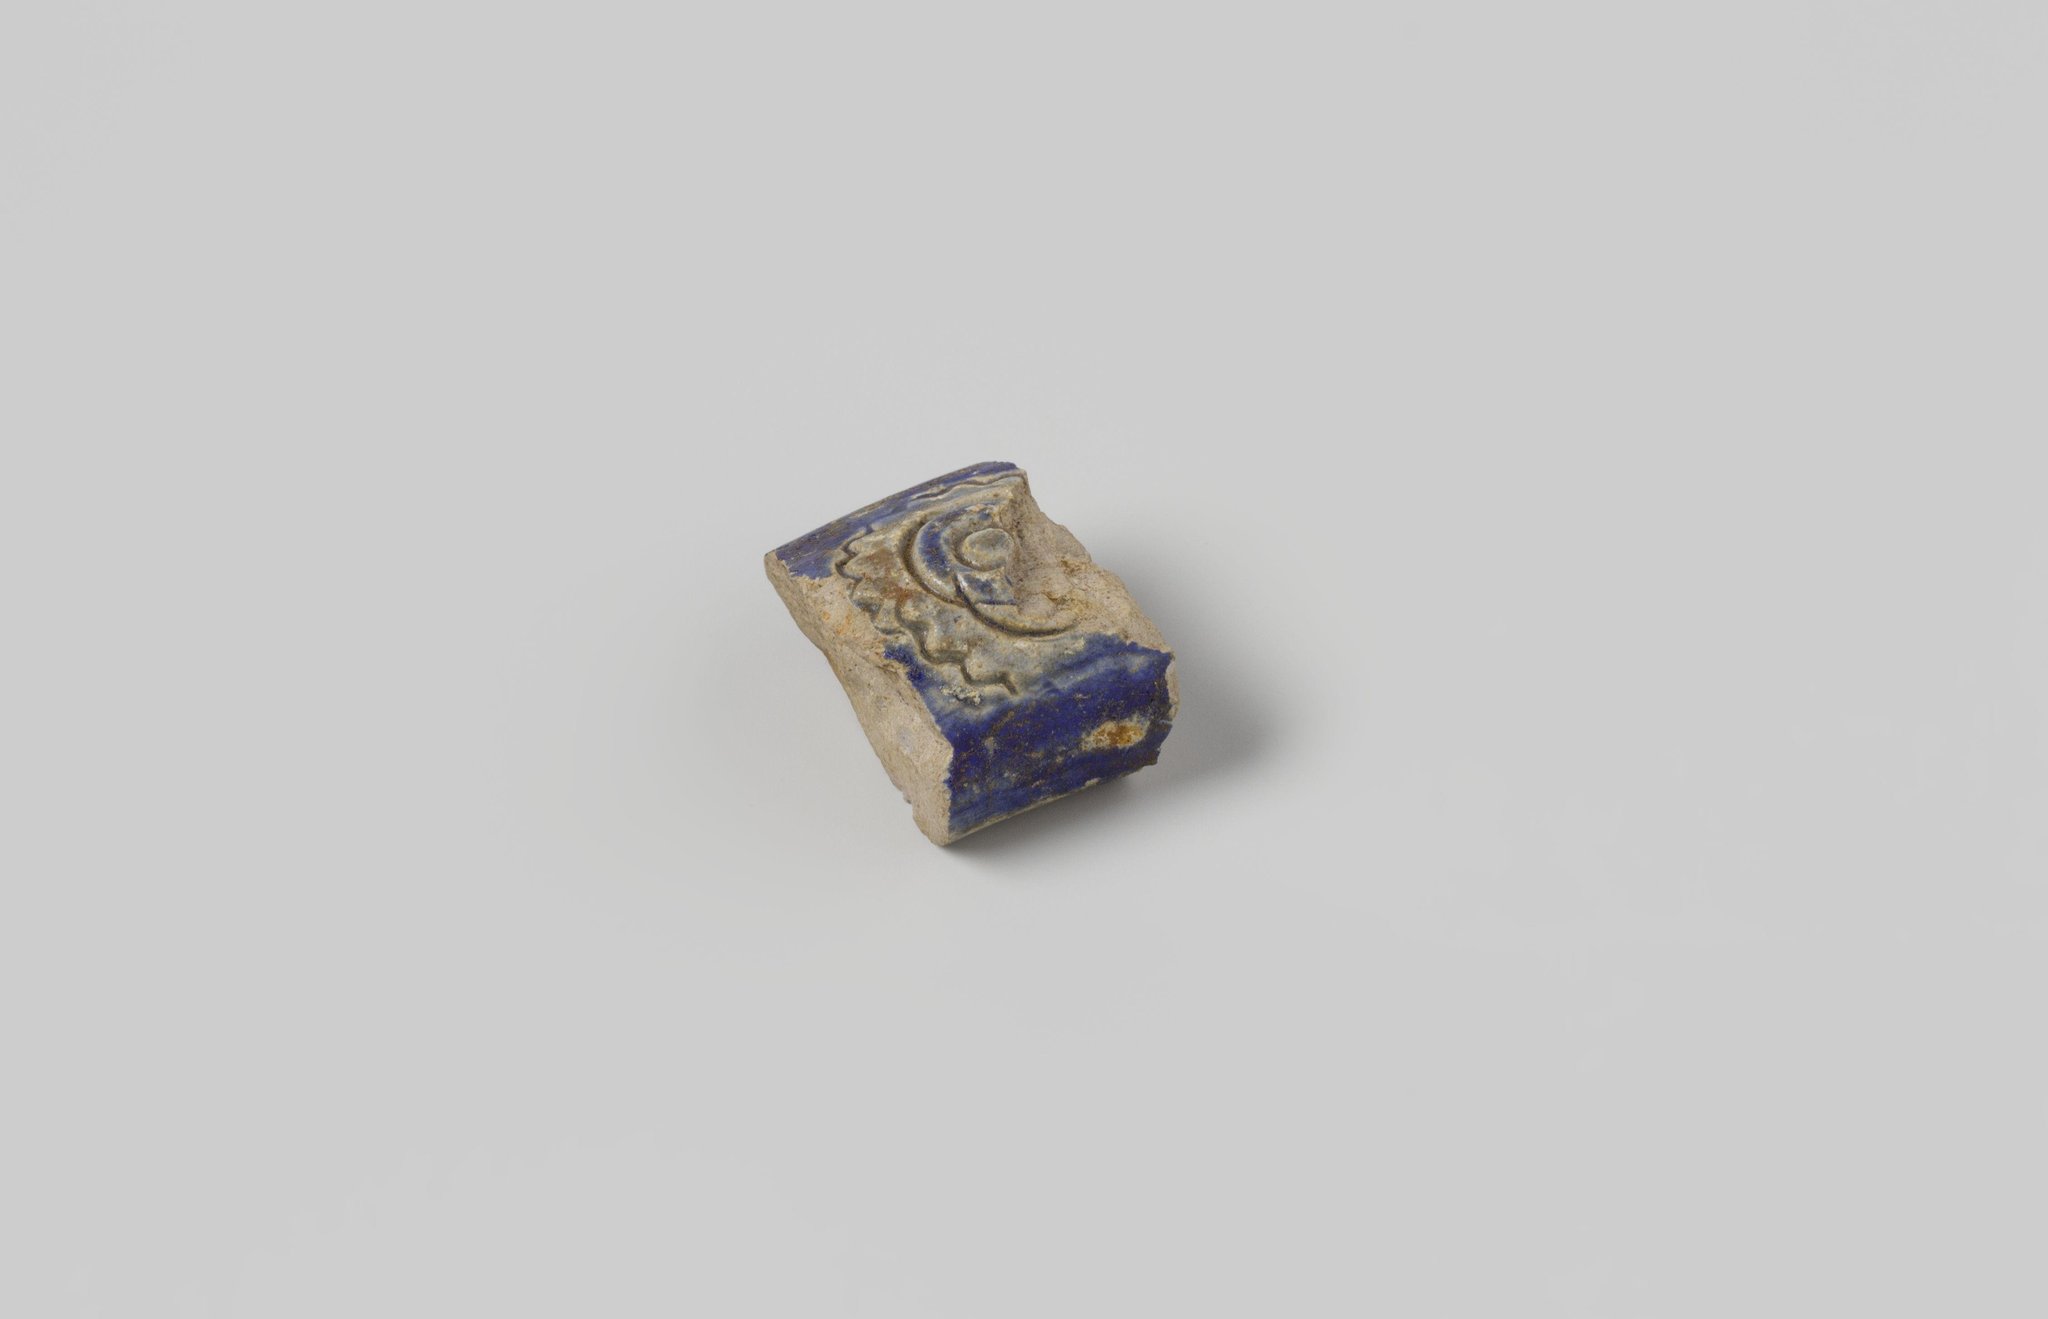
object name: sherd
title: Oor van eenpPot uit het wrak van de Oost-Indiëvaarder Hollandia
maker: Anonymous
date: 1700-1743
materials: stoneware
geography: westerwald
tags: verenigde oostindische compagnie, hollandia (schip), annet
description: Stoneware, Rhenish, Westerwald, pot; of handle, sim. NG 1980-27H2412 with relieved decoration.